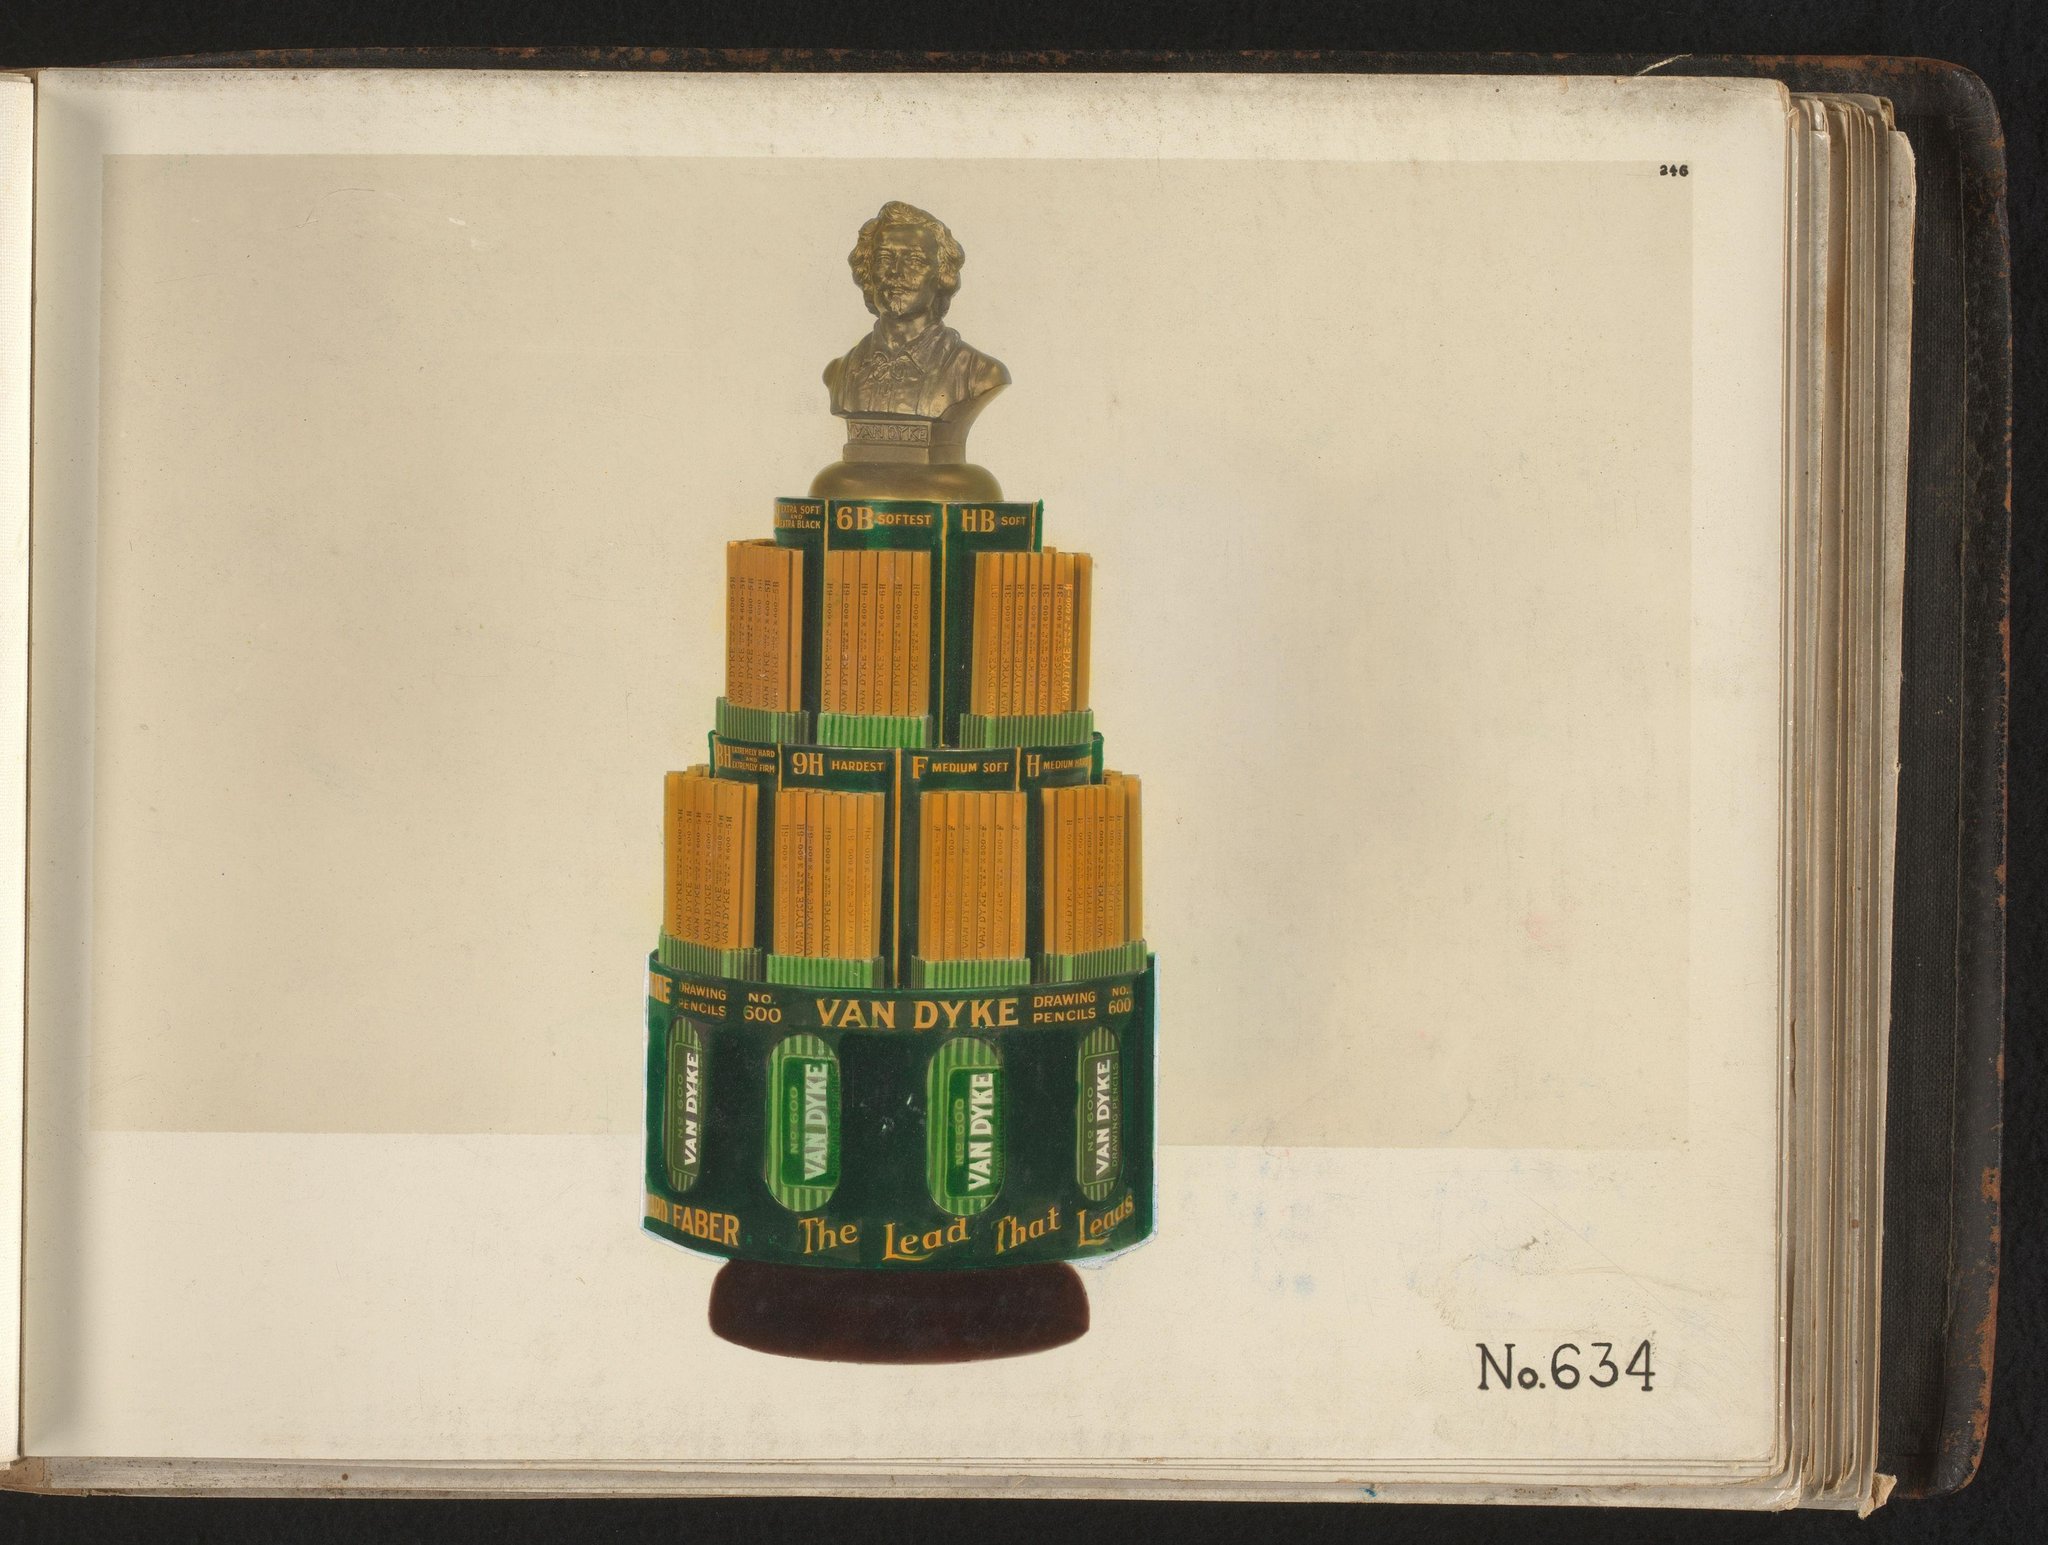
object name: photograph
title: Standaard met potloden van Eberhard Faber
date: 1915-1935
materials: paper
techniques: gelatin silver print, hand coloring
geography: springfield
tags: pencil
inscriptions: stamp: ‘Paramount/ Commercial Studios/ 145 Chestnut St./ Springfield - Mass.’, number: ‘246’